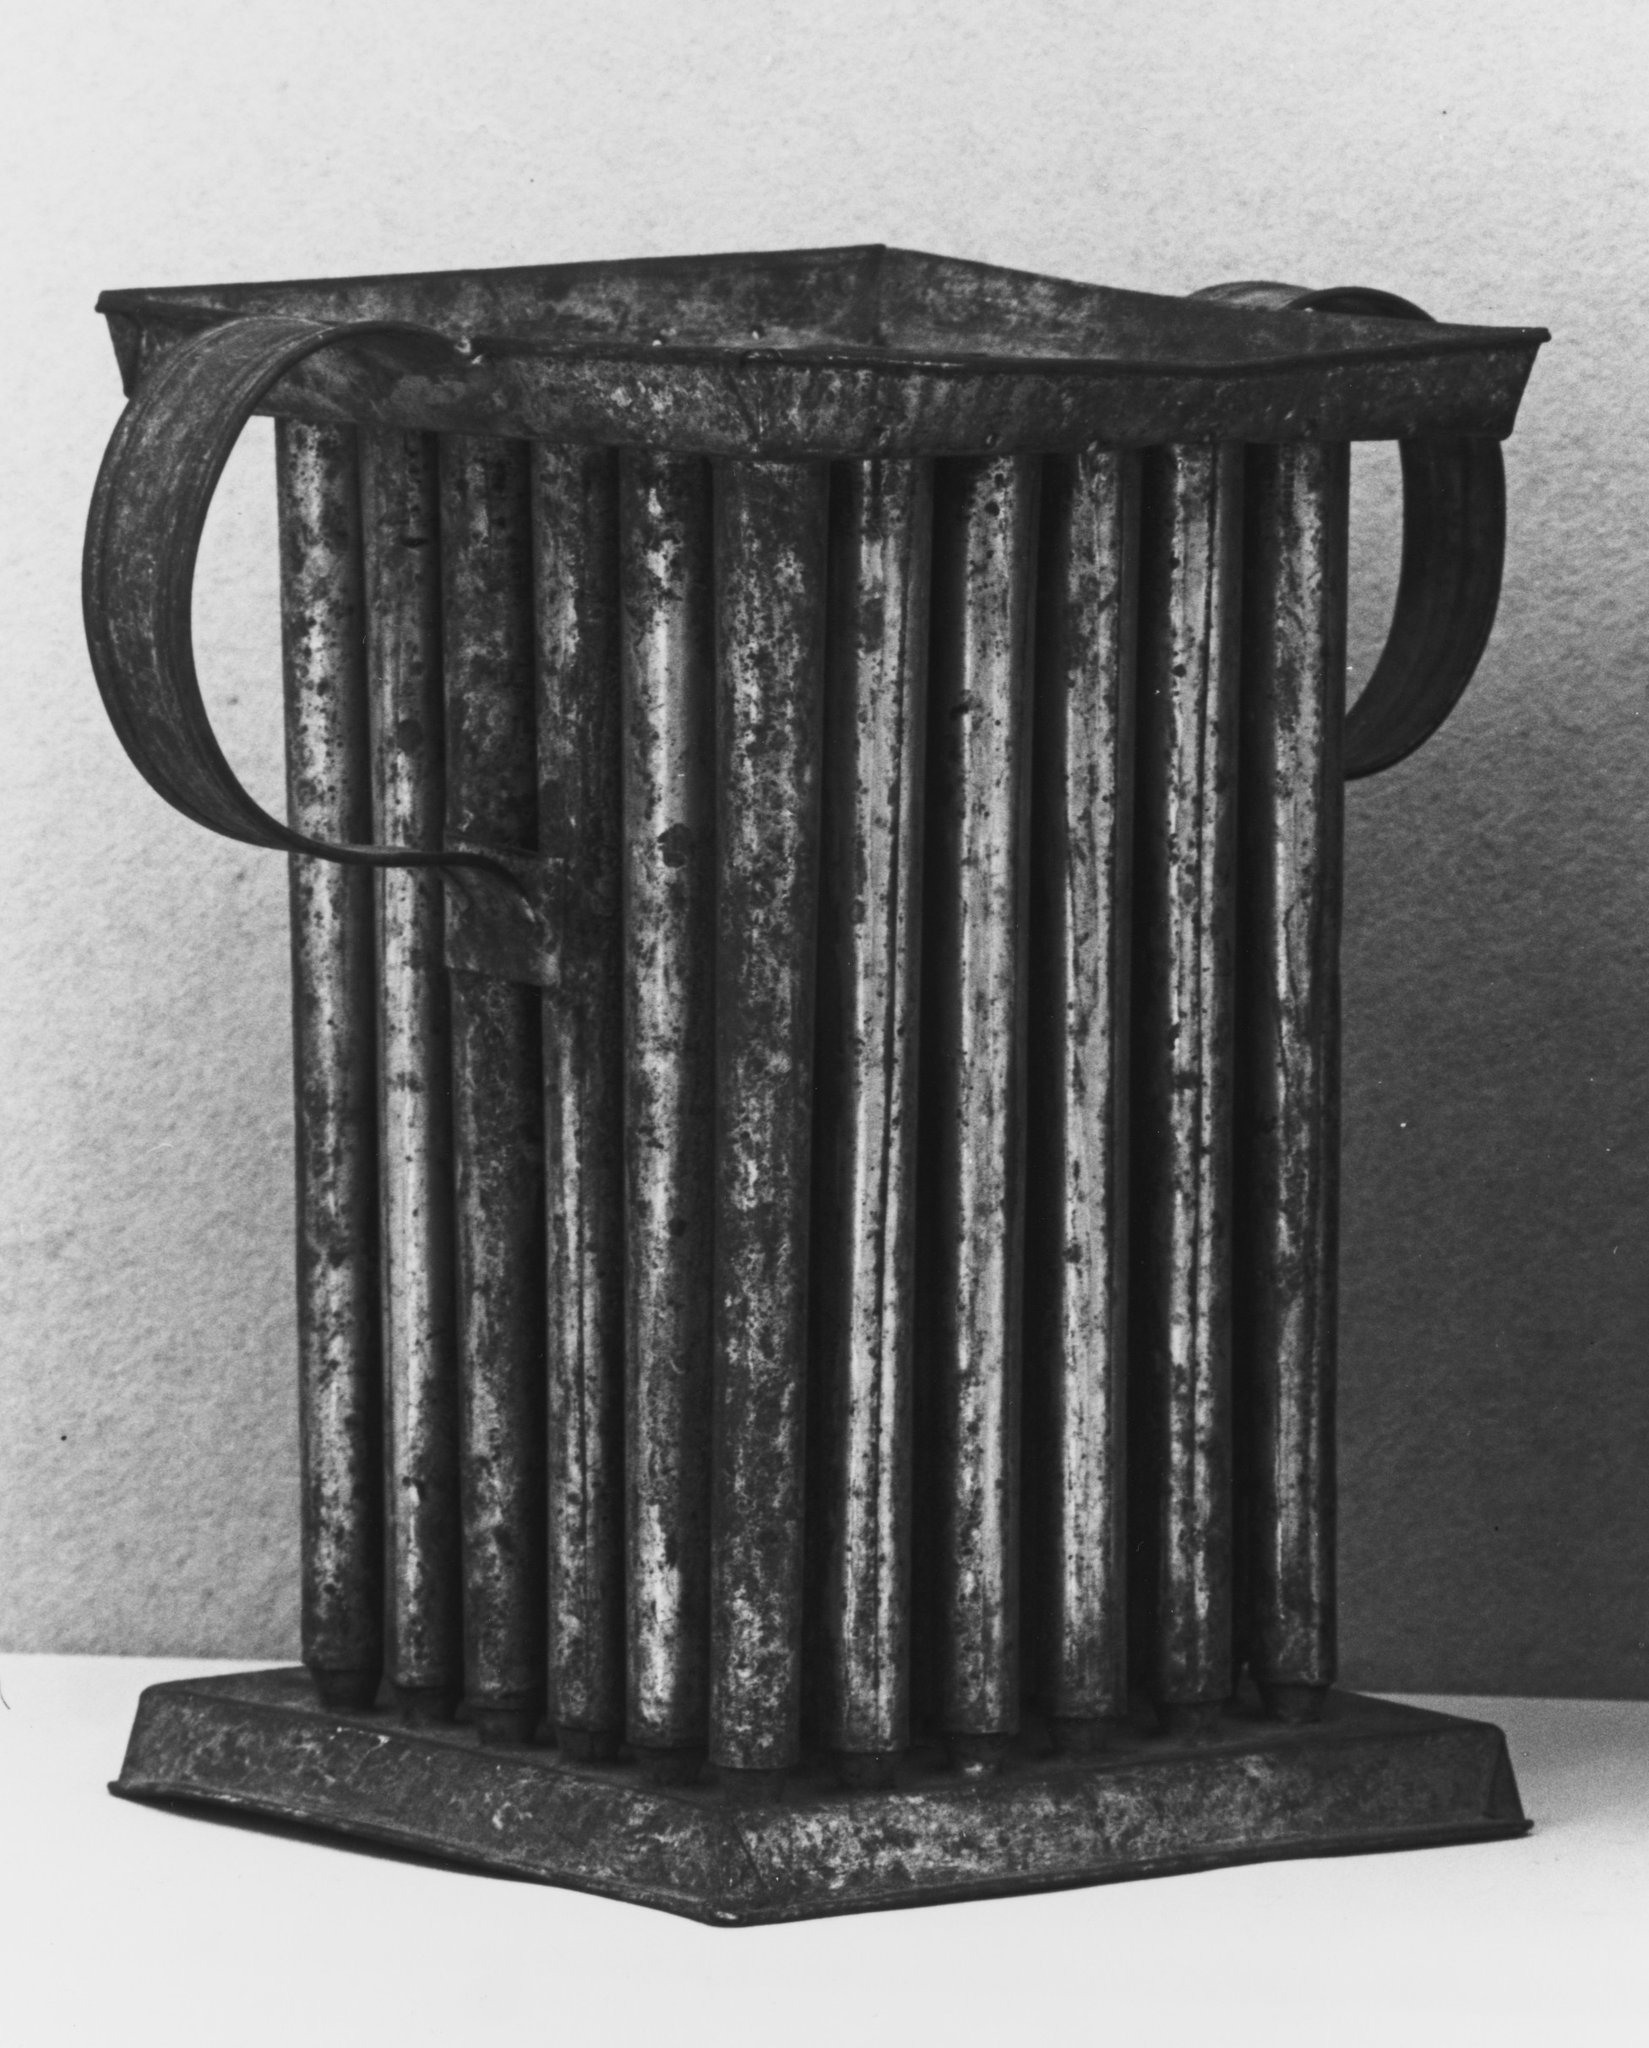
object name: candle mold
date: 1700-1900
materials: tin